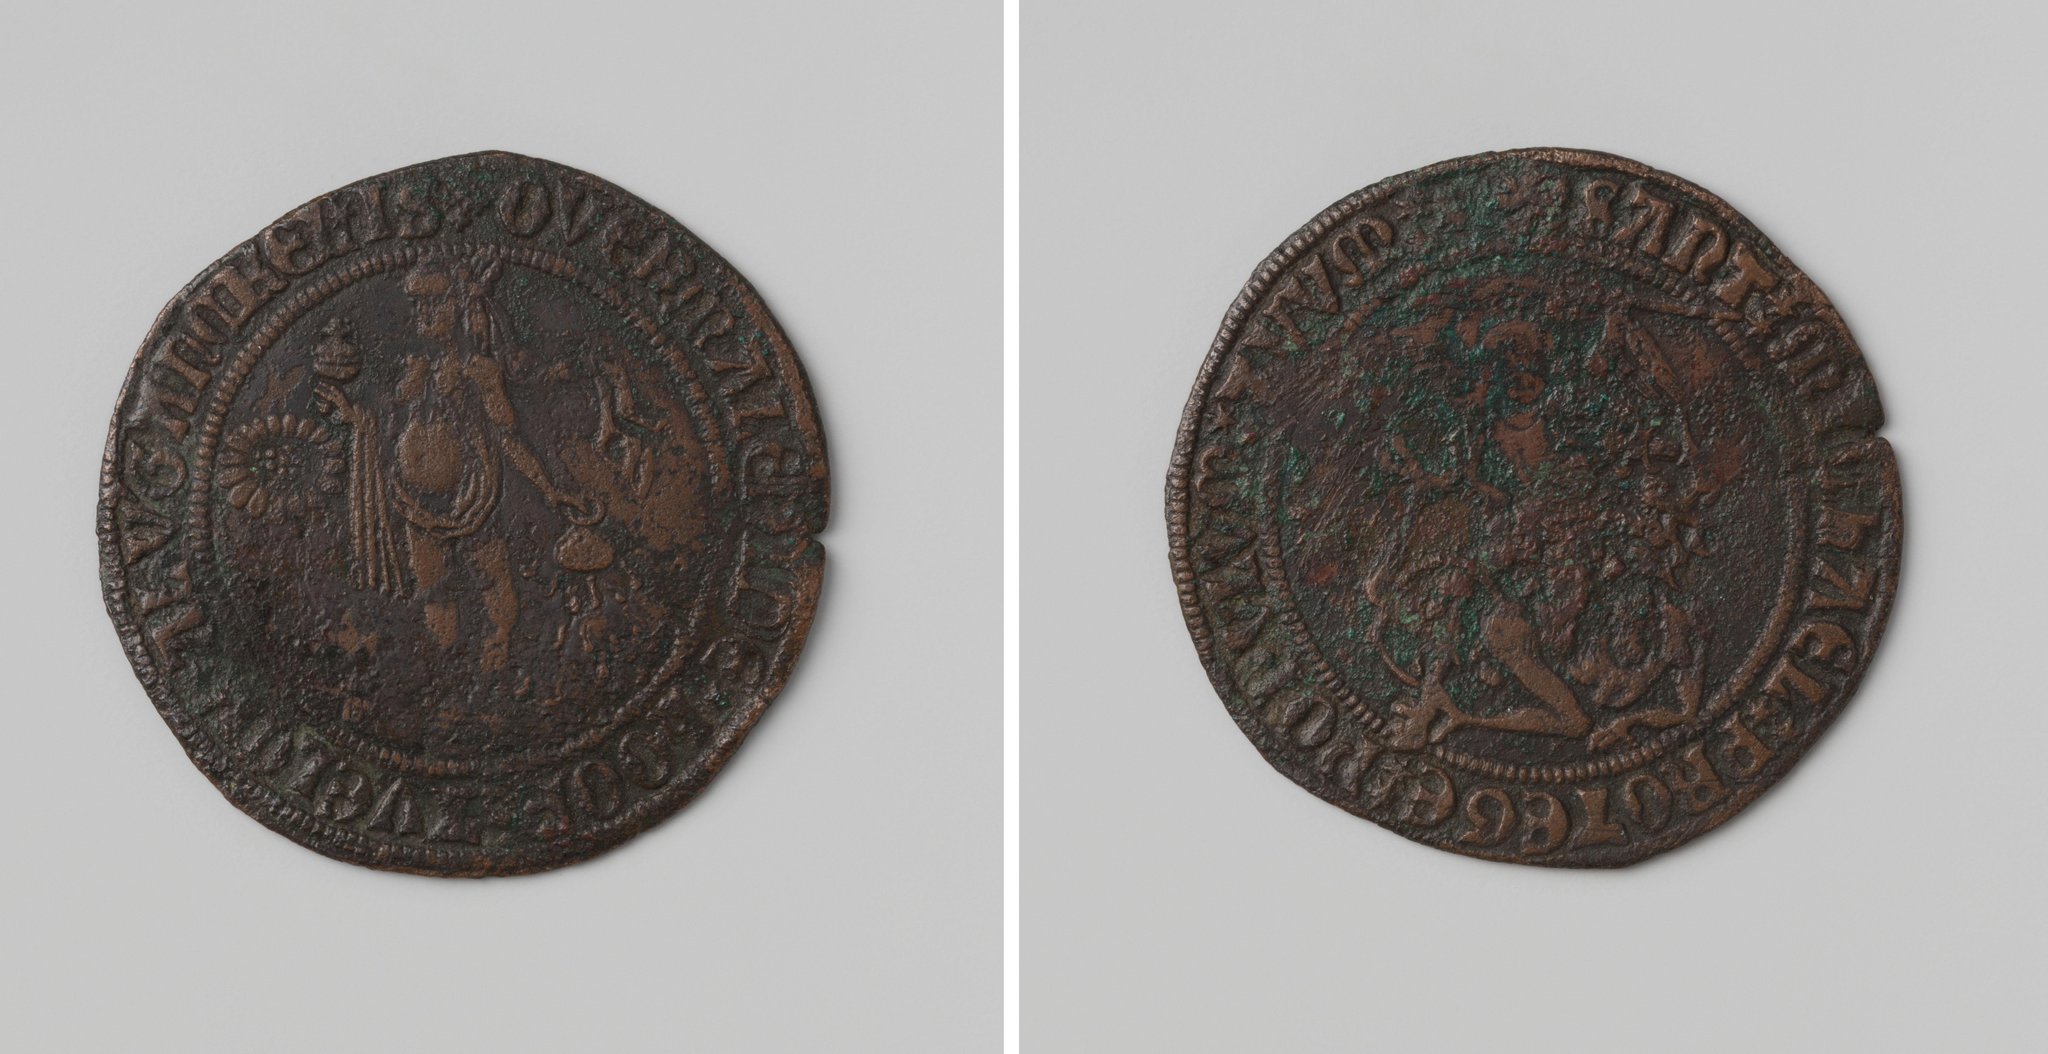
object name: jeton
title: Allegorie op de slechte tijden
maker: Anonymous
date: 1506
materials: copper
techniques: striking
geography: netherlands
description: Koperen penning. Voorzijde: naakte vrouw met in geheven rechterhand een rijksappel en in linkerhand beker, waar vonken uitkomen binnen omschrift. Keerzijde: St. vertrapt ter aarde liggend monster binnen omschrift